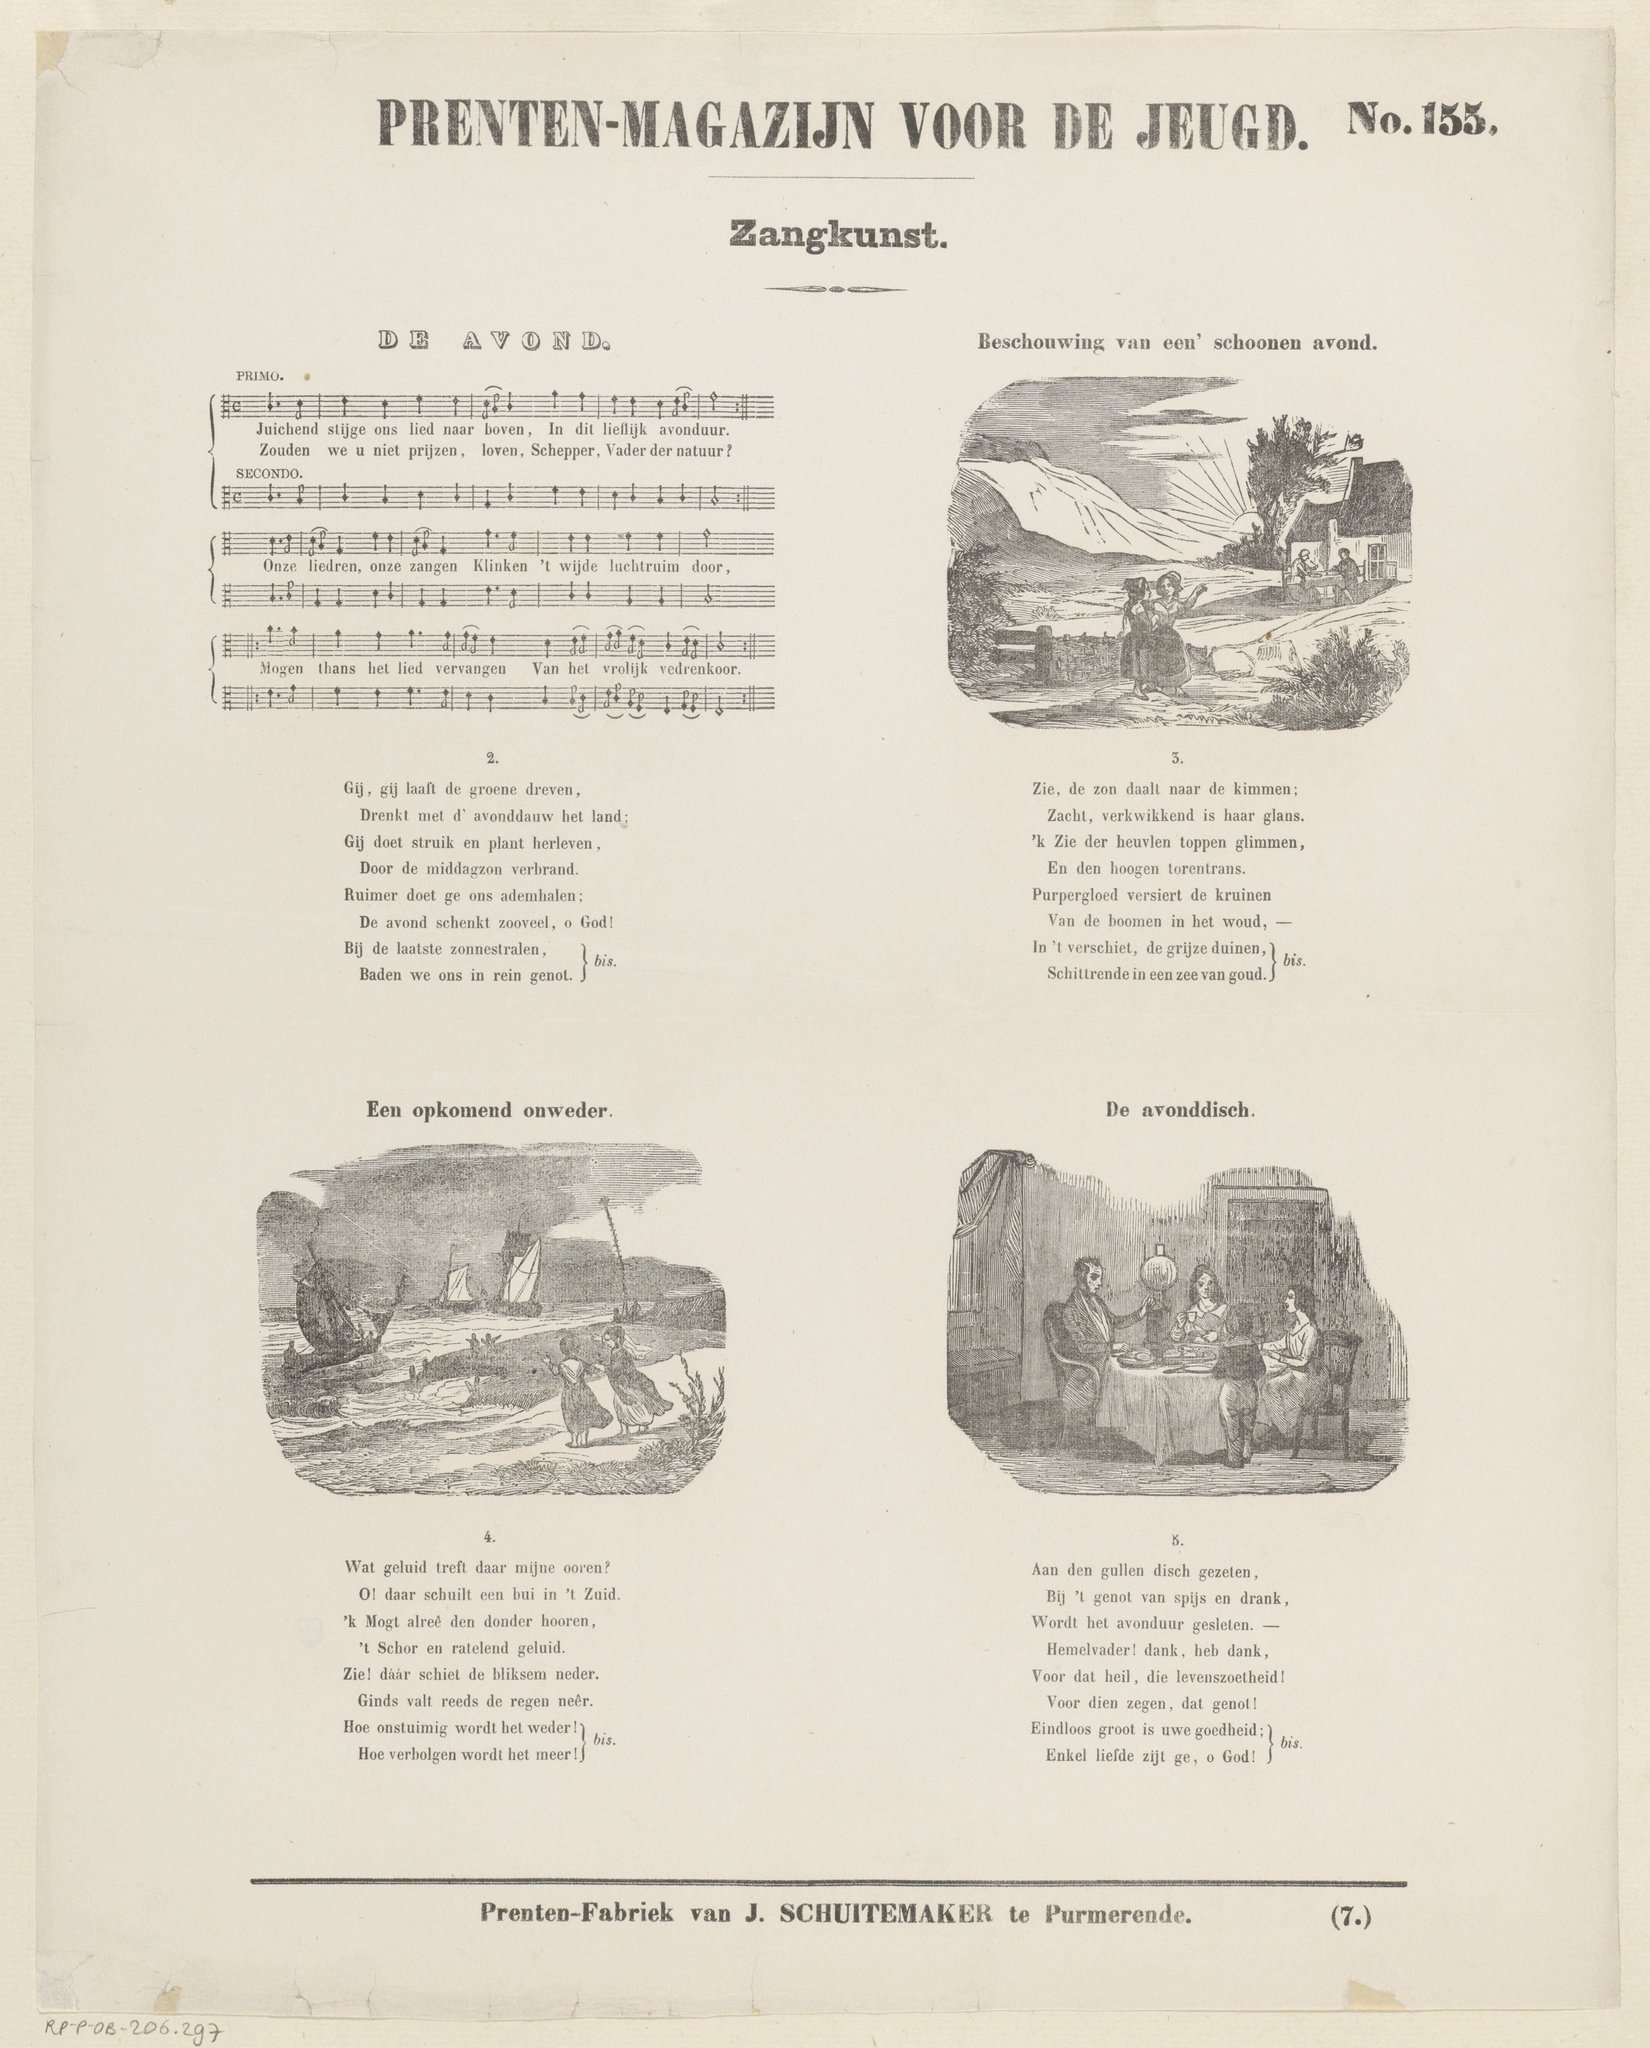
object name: print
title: De avond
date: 1850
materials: paper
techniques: letterpress printing, engraving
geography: purmerend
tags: evening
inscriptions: collector's mark: Lugt 2760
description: Na voltooiing van de acht jaargangen van de reeks 'Prenten-magazijn voor de jeugd' in 1850 heeft Jan Schuitemaker al deze prenten heruitgegeven en omgenummerd als nr. 1 t/m 192. De oorspronkelijke jaargang wordt telkens nog vermeld rechtsonder op de prent. Binnen de jaargangen zijn prenten van hetzelfde thema in clusters van vier achter elkaar gezet.